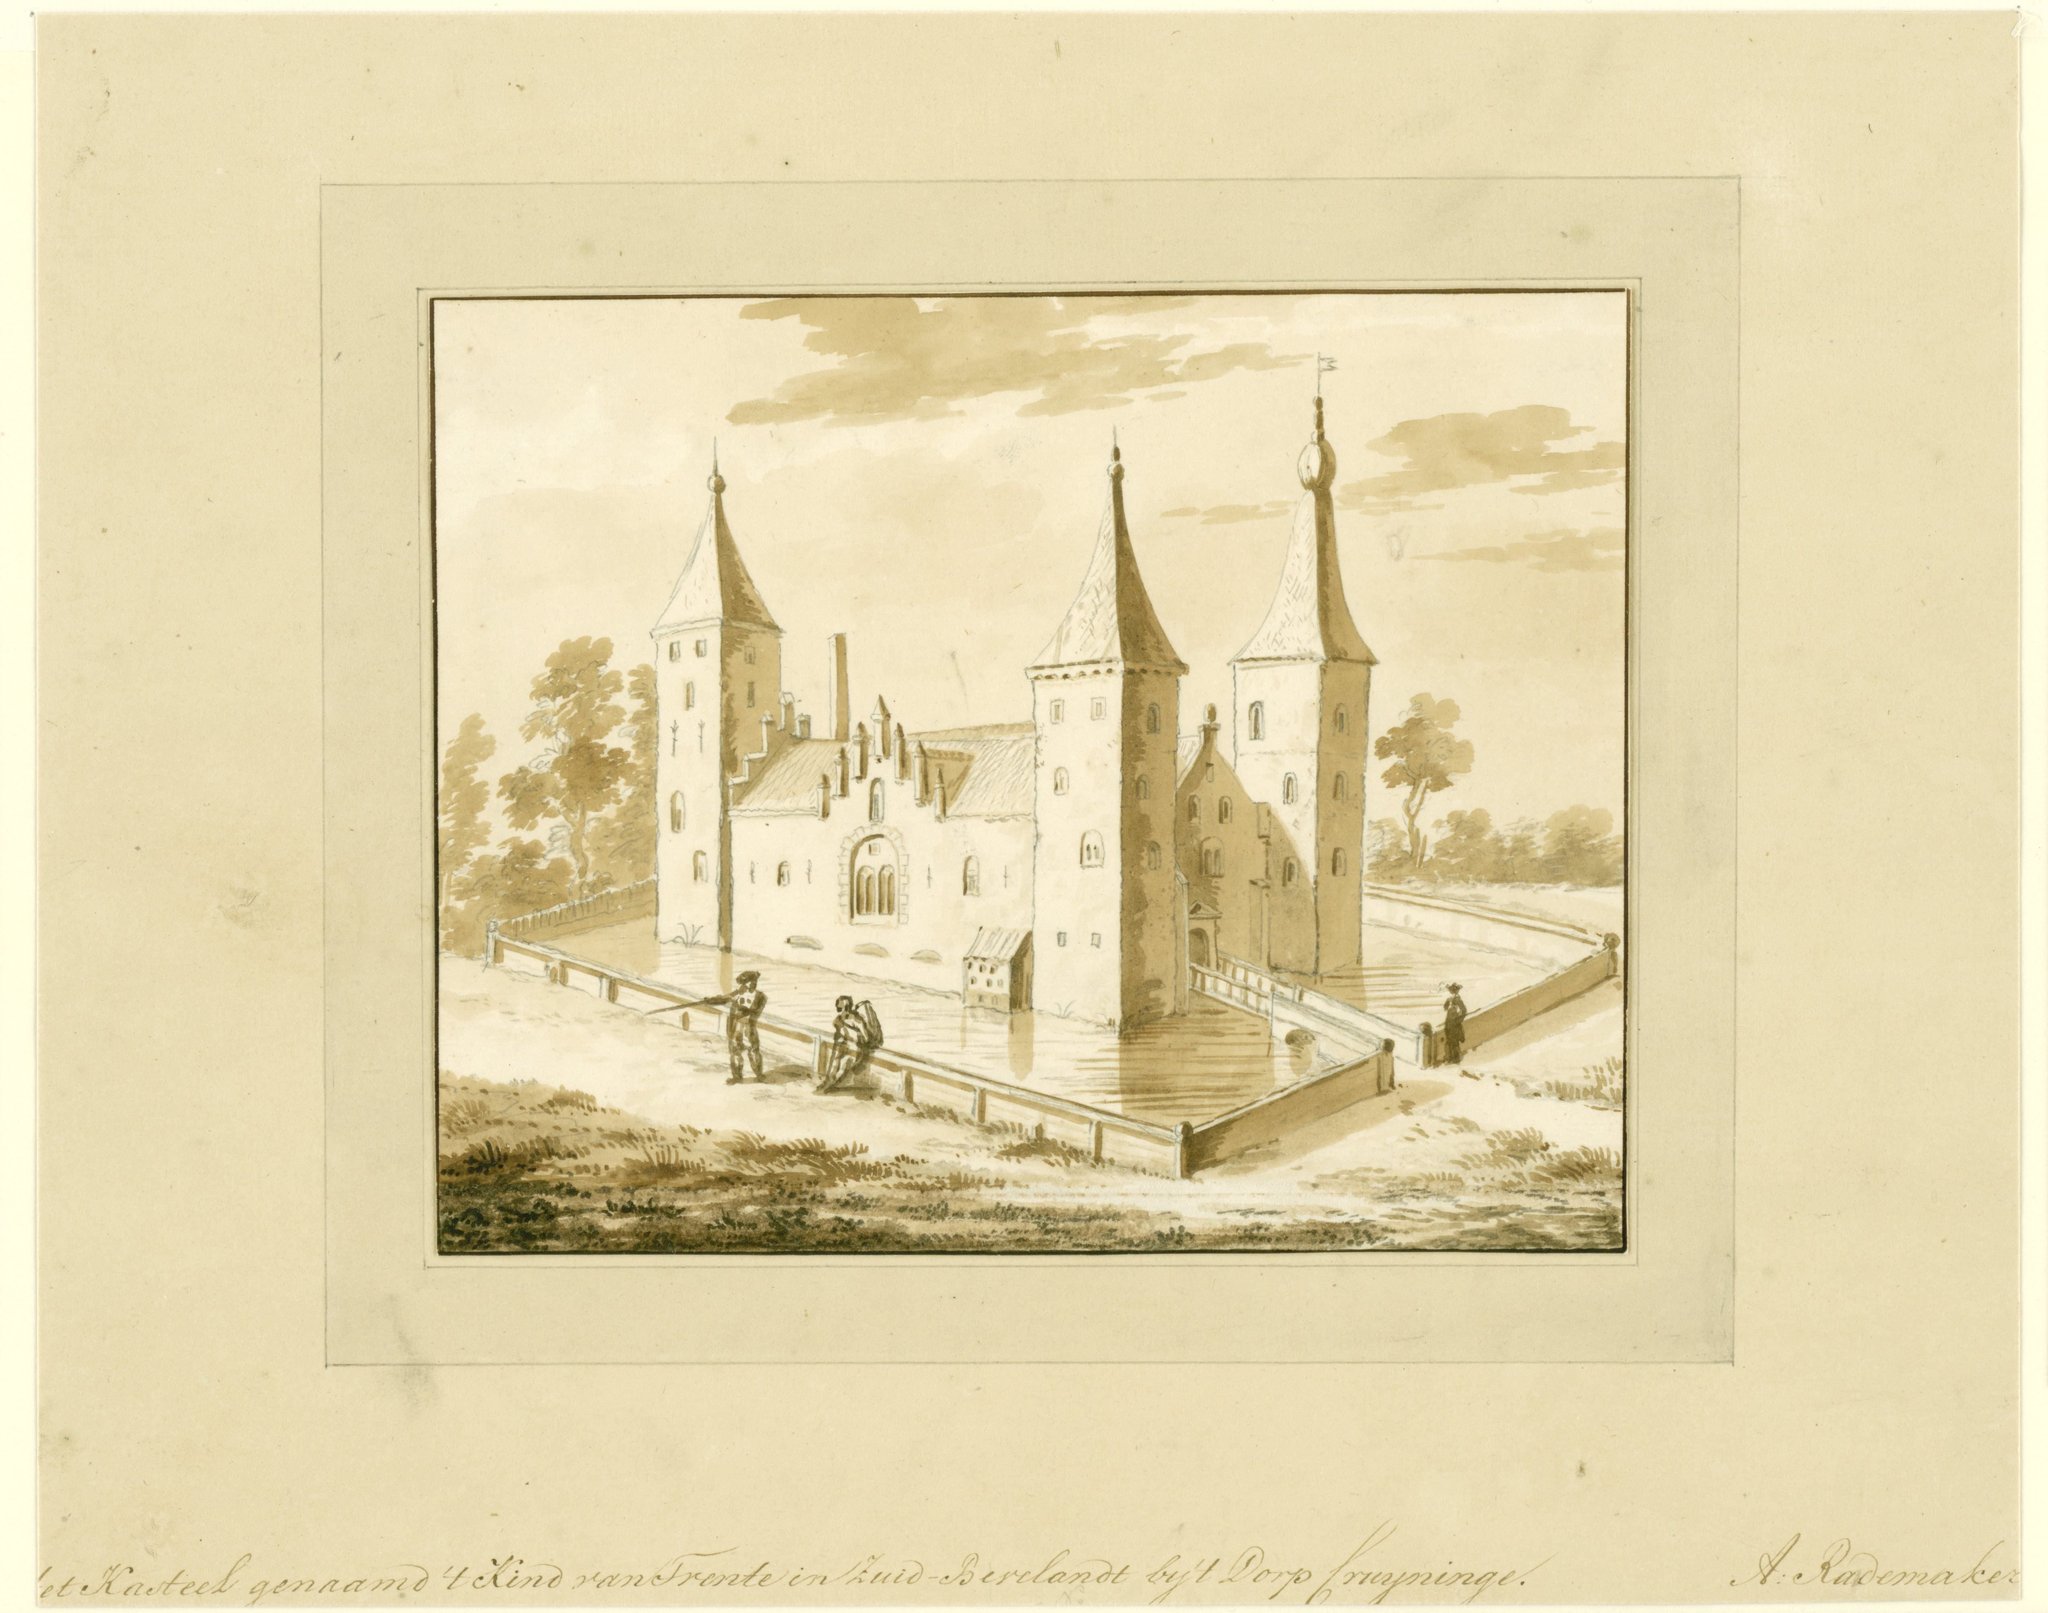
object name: drawing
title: Kasteel 't Kind van Trente bij Kruiningen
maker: abraham rademaker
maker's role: draughtsman, print maker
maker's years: 1676-1735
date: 1685-1735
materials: paper, pencil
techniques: brush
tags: castle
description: Kasteel genaamd 't Kind van Trente, in Zuid-Beveland bij het dorp Kruiningen.